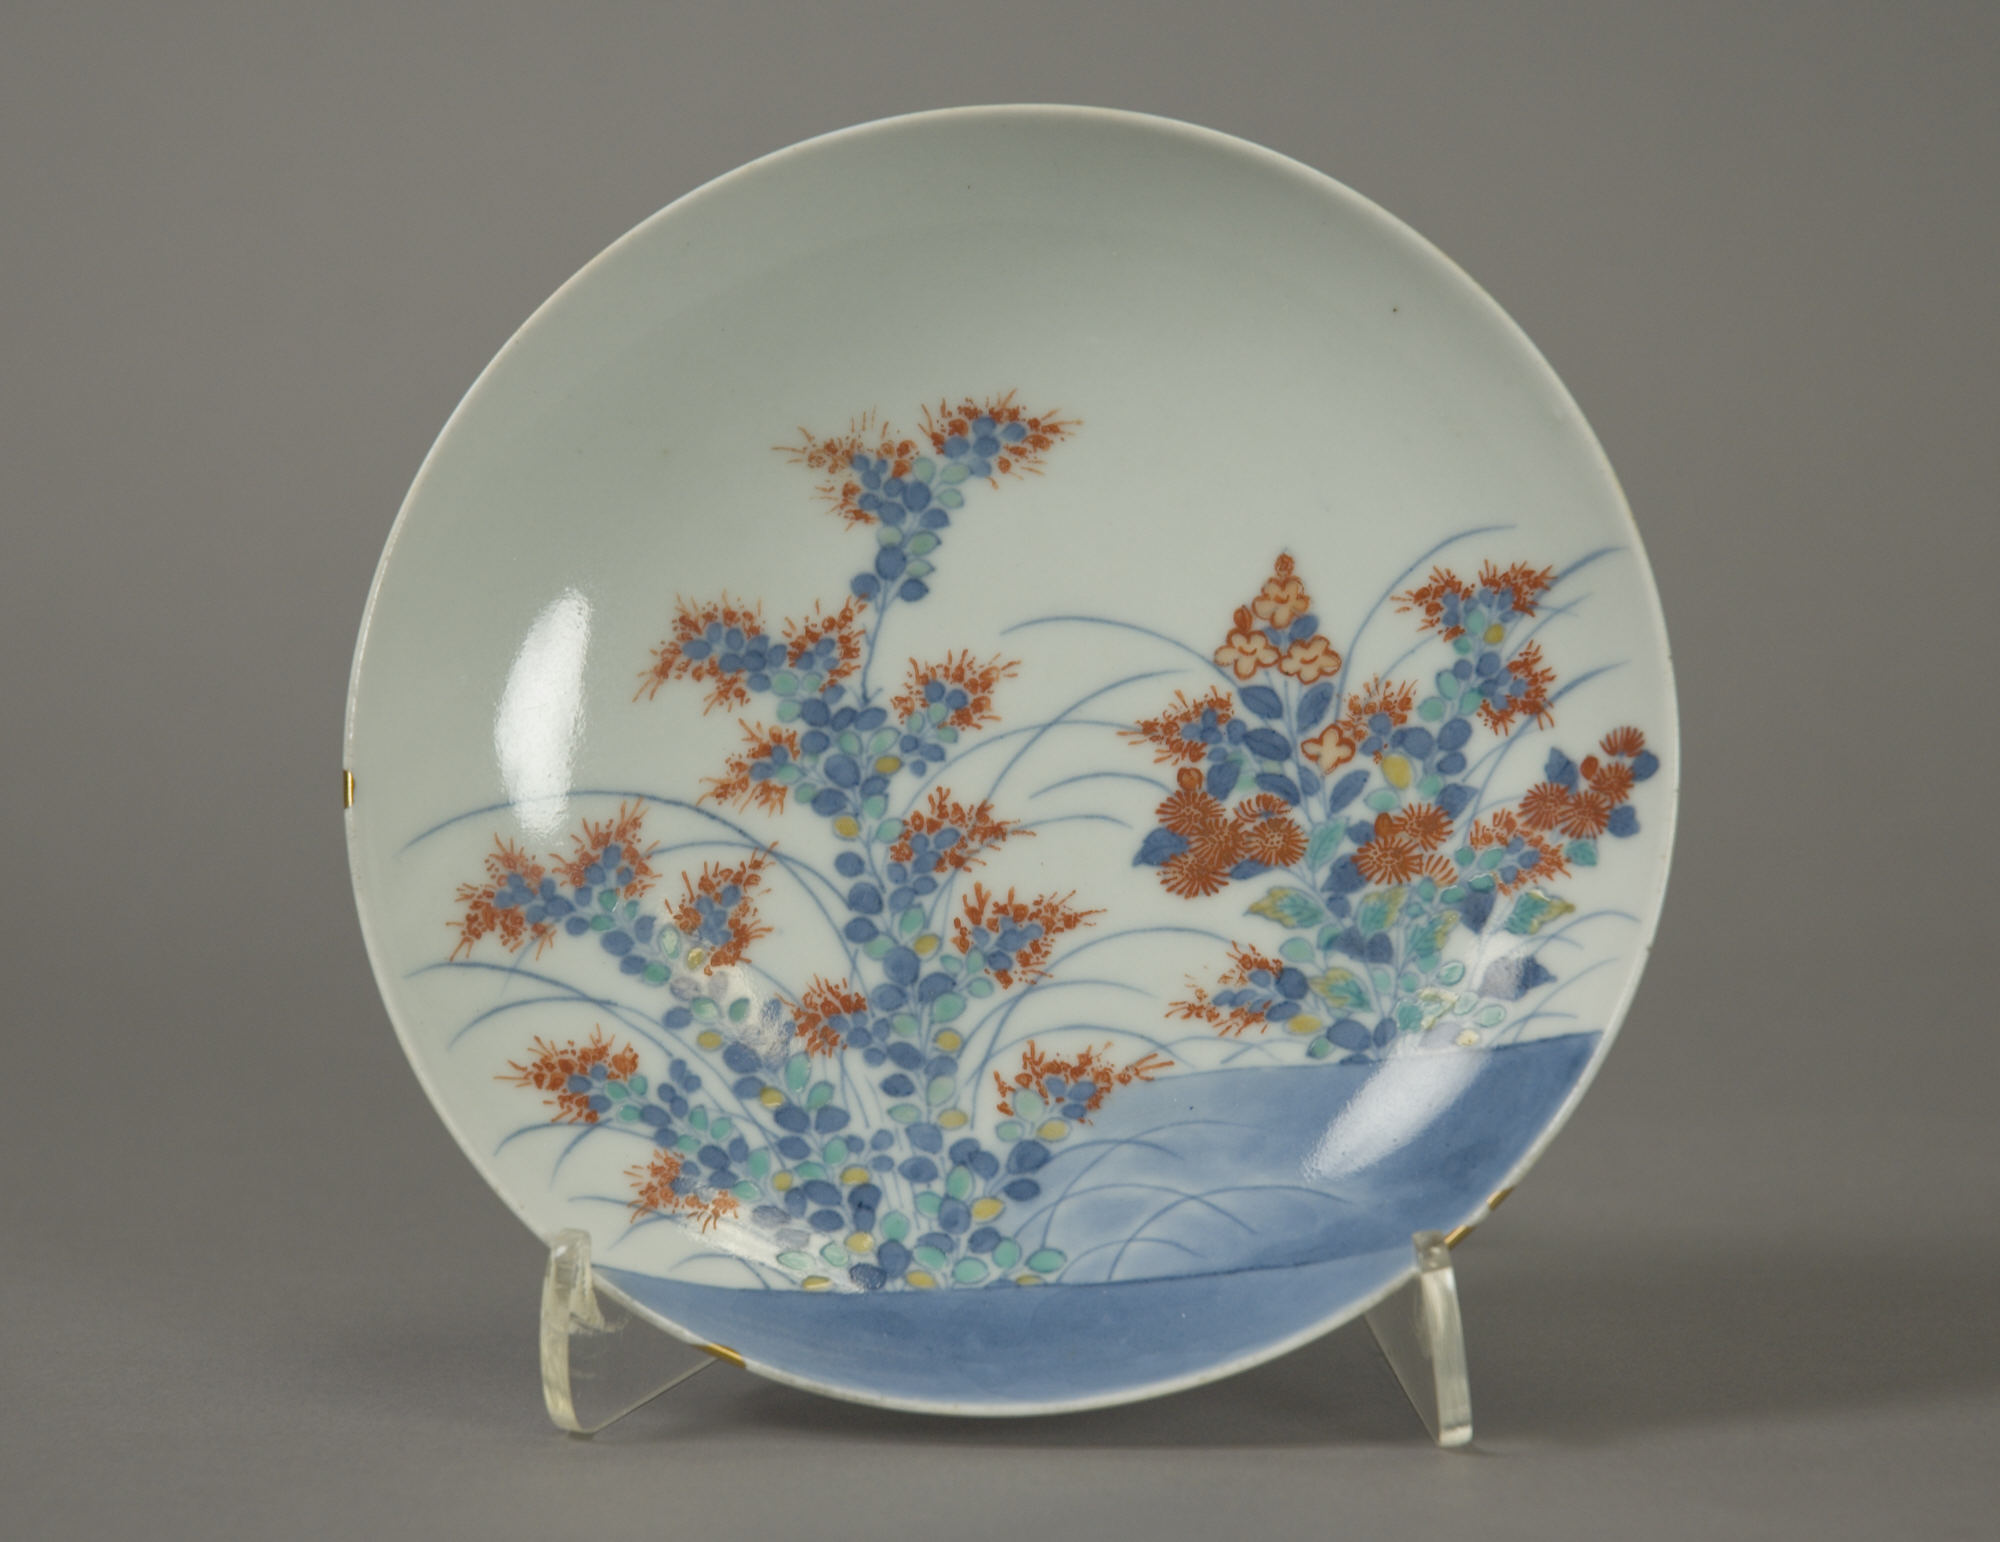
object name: dish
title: Small Dish with Design of Chrysanthemums and Autumn Grasses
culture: japanese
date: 1701-1900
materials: porcelain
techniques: overglaze, underglaze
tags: flowers,plants